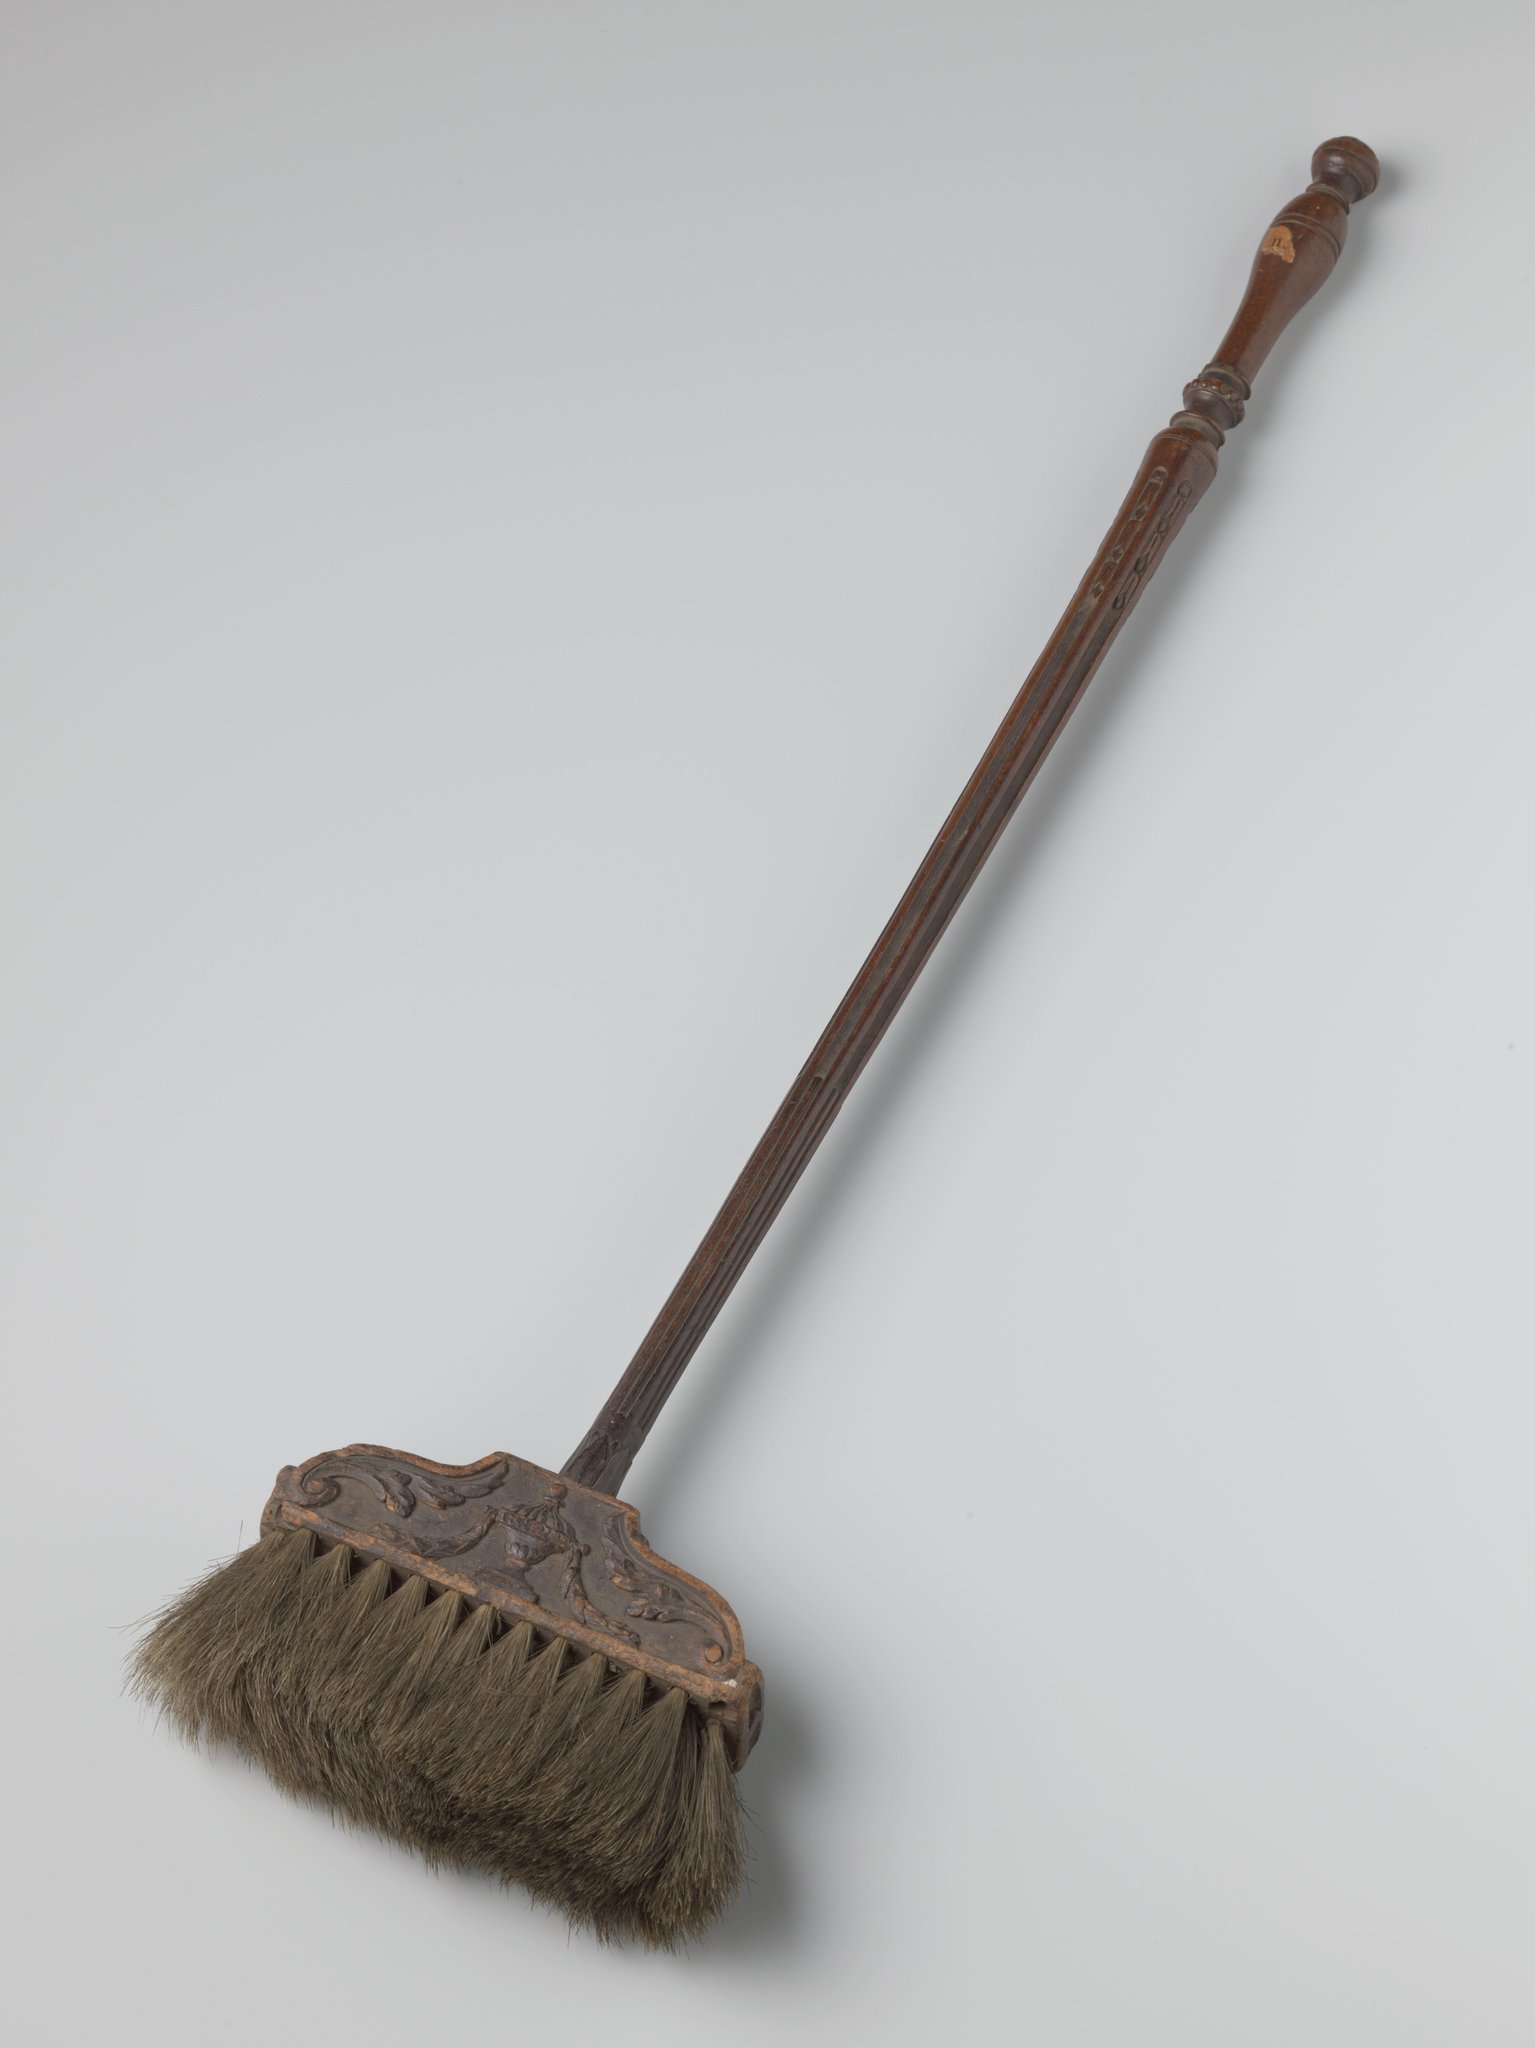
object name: whisk broom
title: Gesneden houten stoffer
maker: Anonymous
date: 1700-1800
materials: hair, wood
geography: northern netherlands